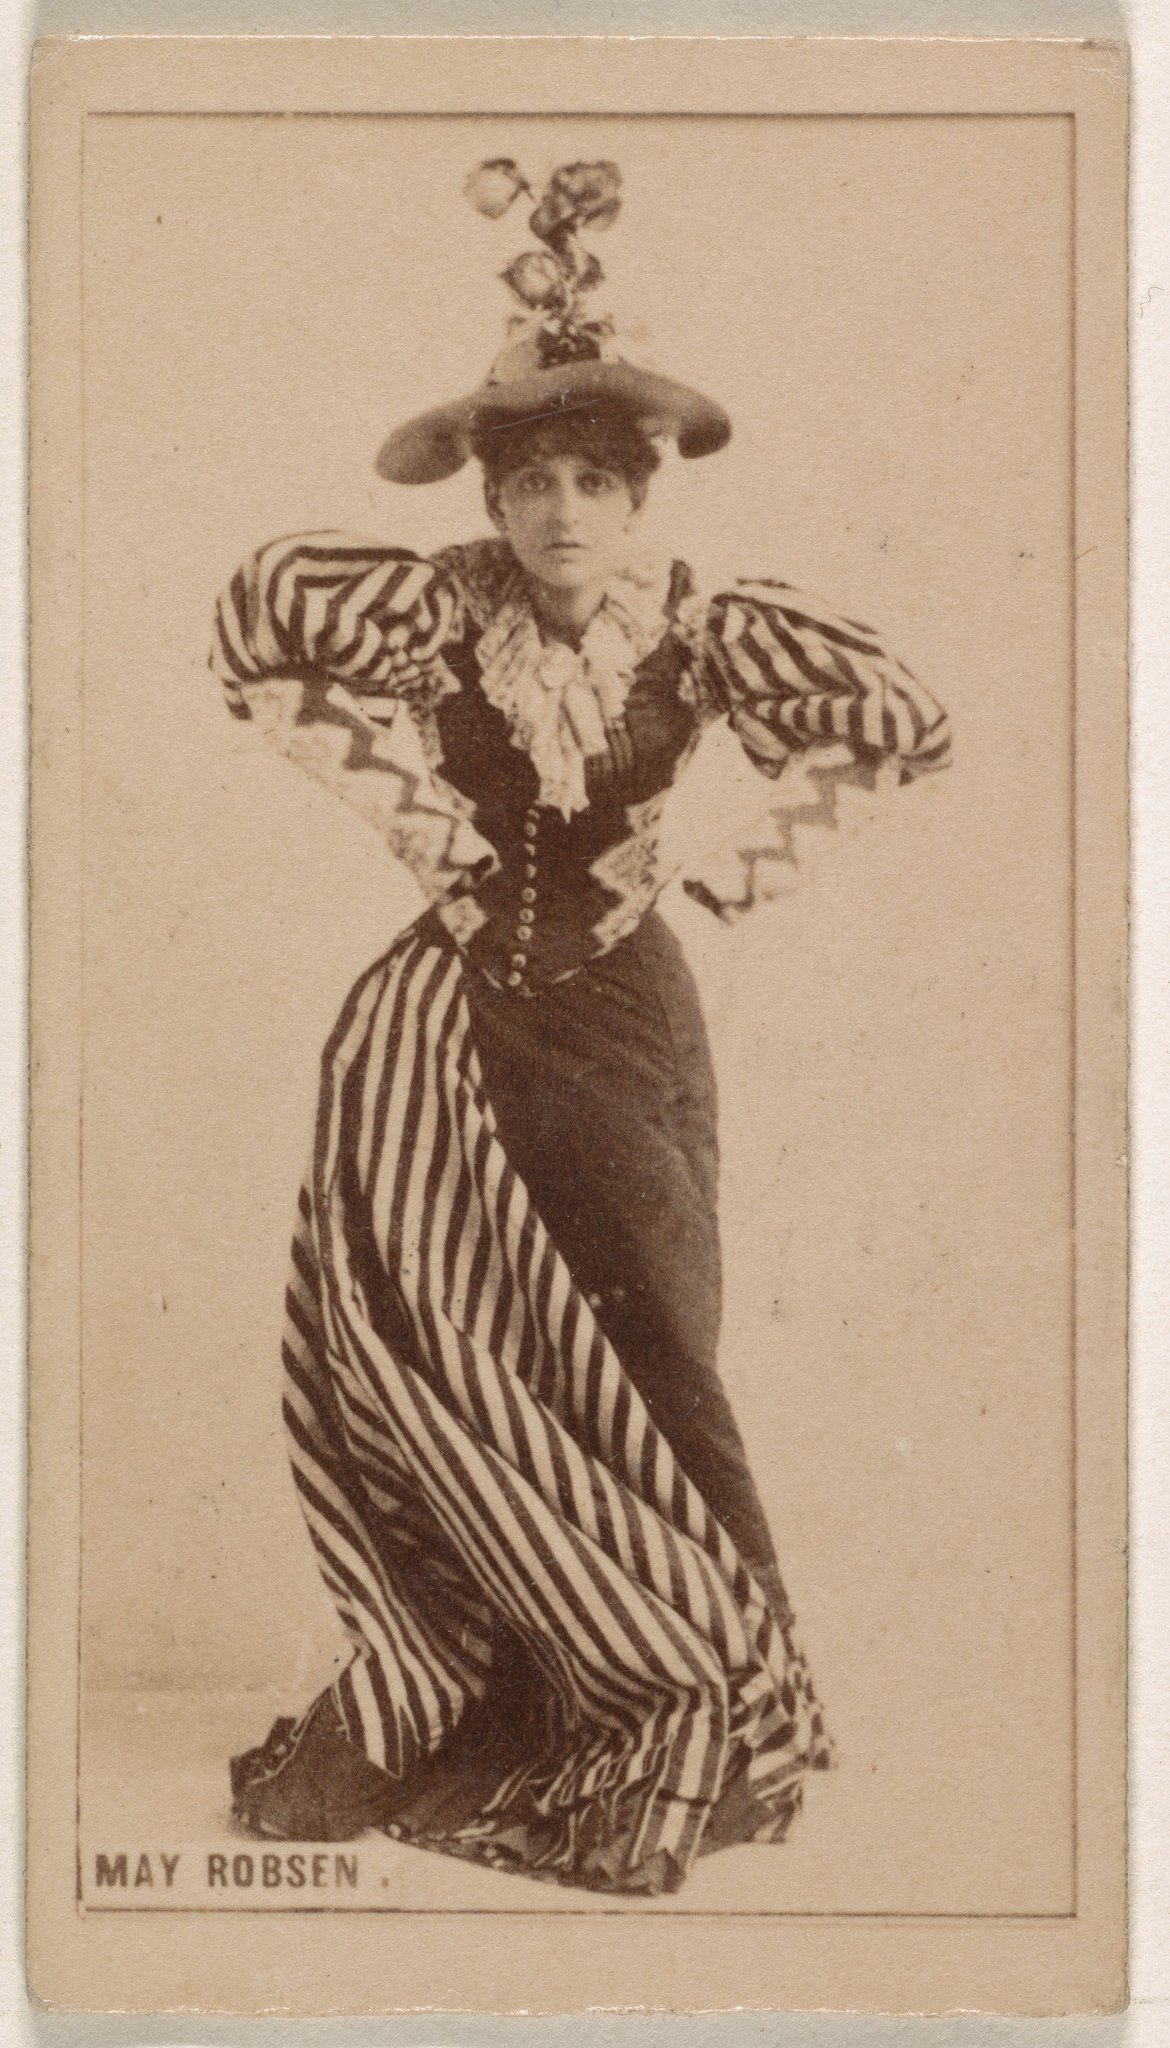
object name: photograph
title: May Robson, from the Actresses series (N245) issued by Kinney Brothers to promote Sweet Caporal Cigarettes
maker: kinney brothers tobacco company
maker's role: publisher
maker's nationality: american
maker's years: 1869-2011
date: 1890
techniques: albumen silver print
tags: portraits,women,actresses